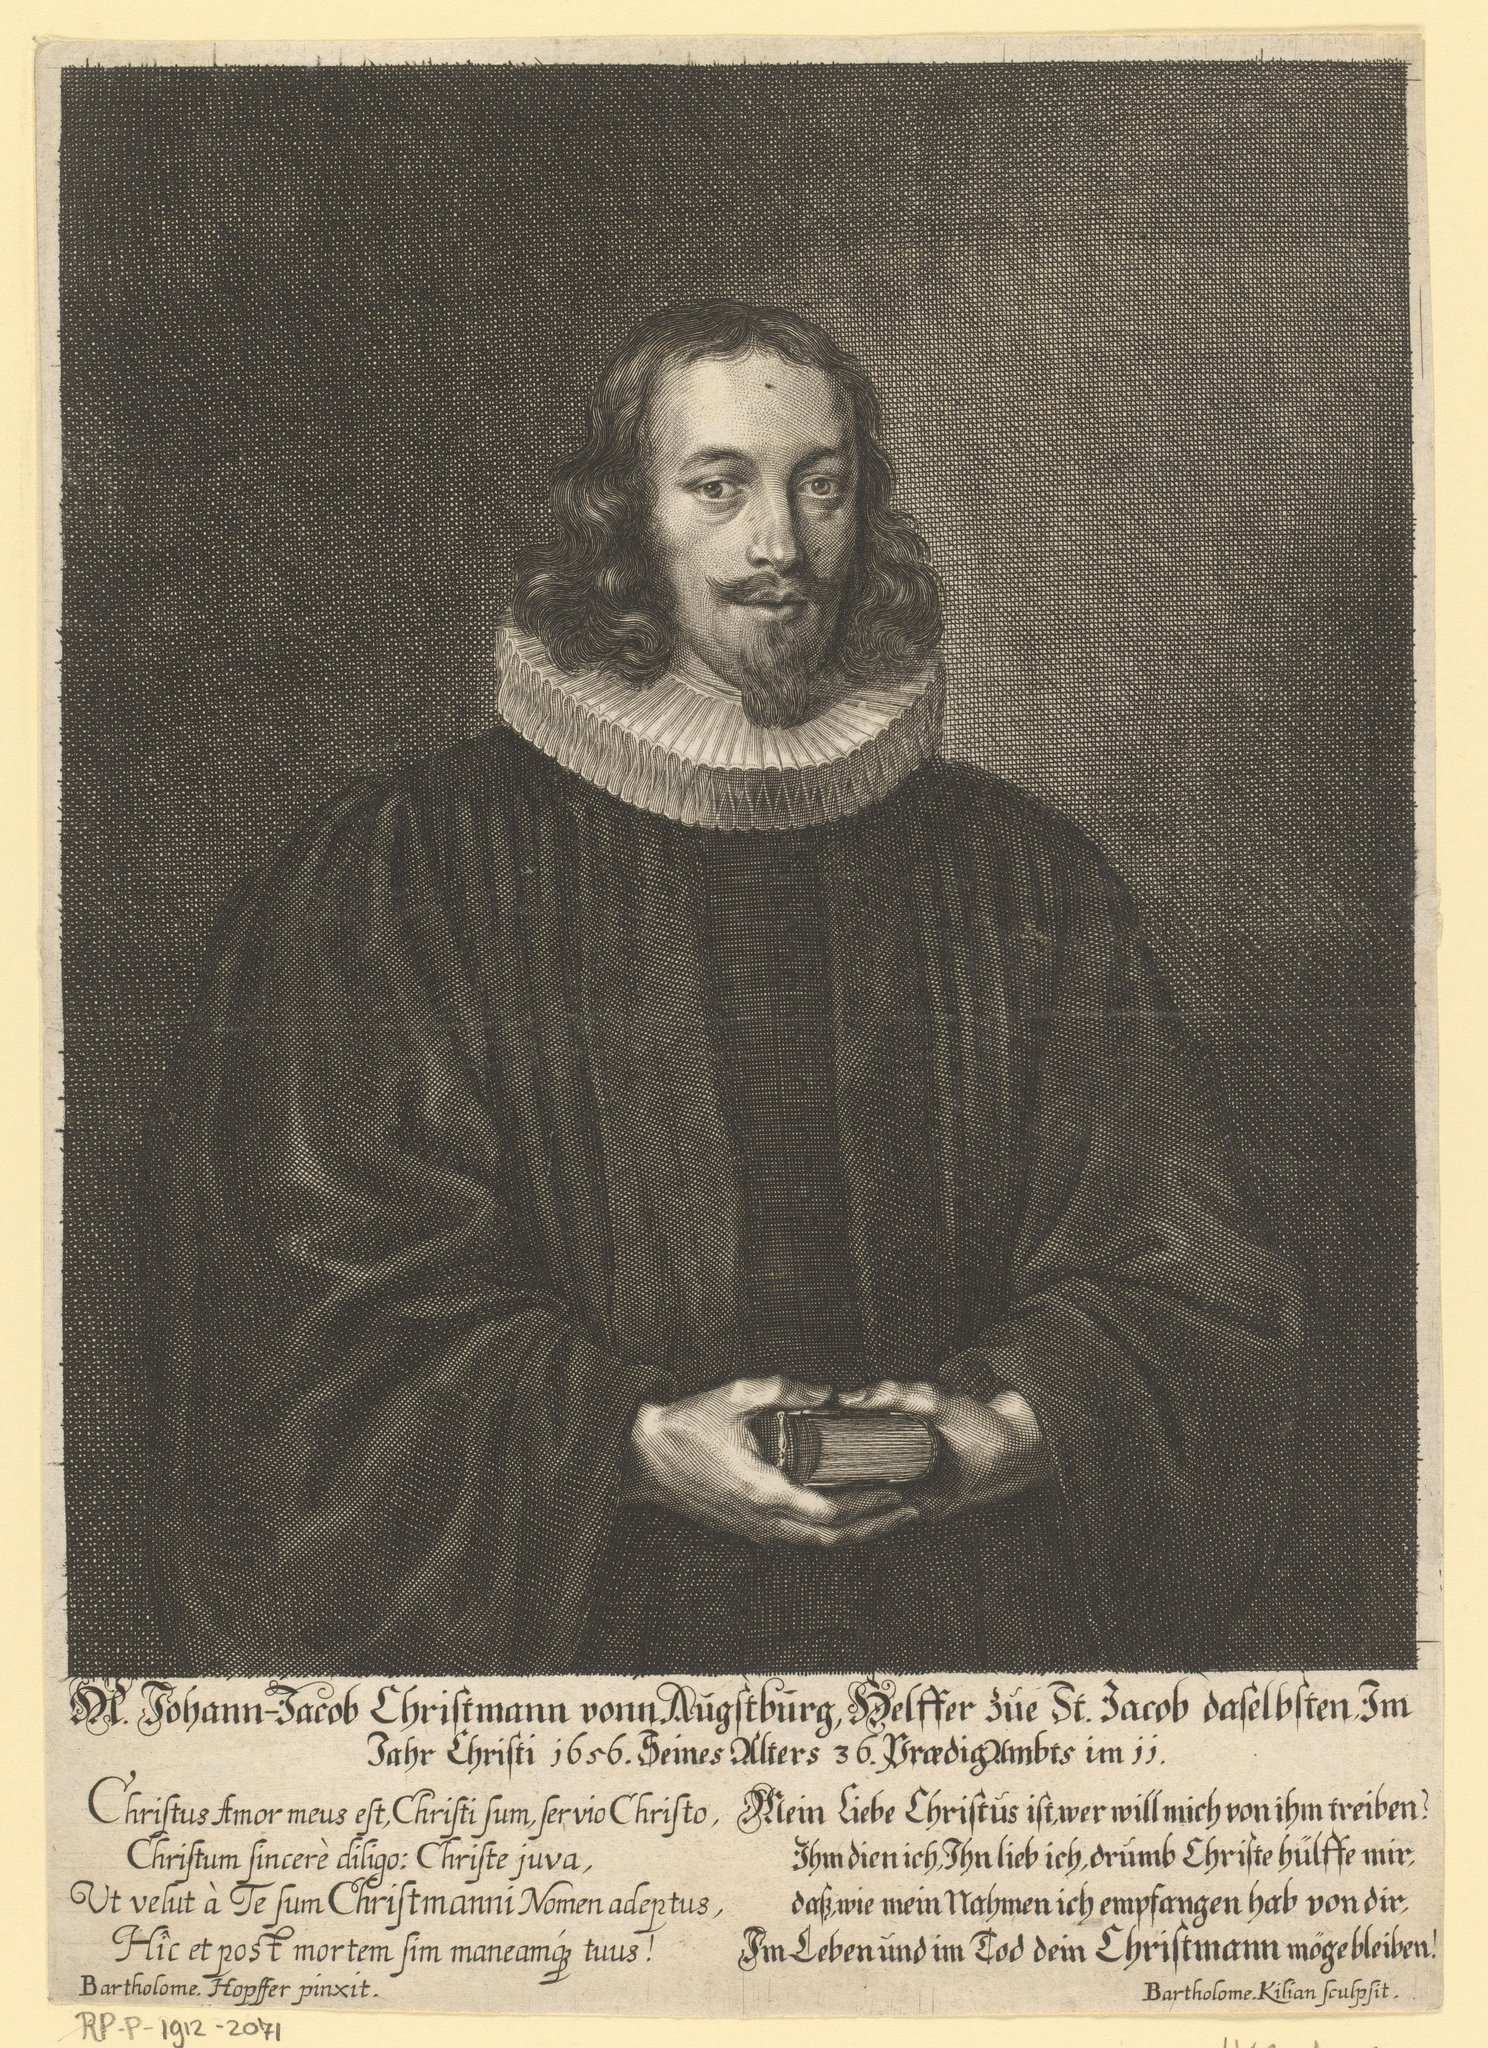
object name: print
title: Portret van Johann Jacob Christmann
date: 1656-1696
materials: paper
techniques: engraving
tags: augsburg, johann jacob christmann, historical persons, book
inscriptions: collector's mark: Lugt 2228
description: Onder het portret een beschrijving van de geportretteerde en een vierregelig vers in het Duits en Latijn.